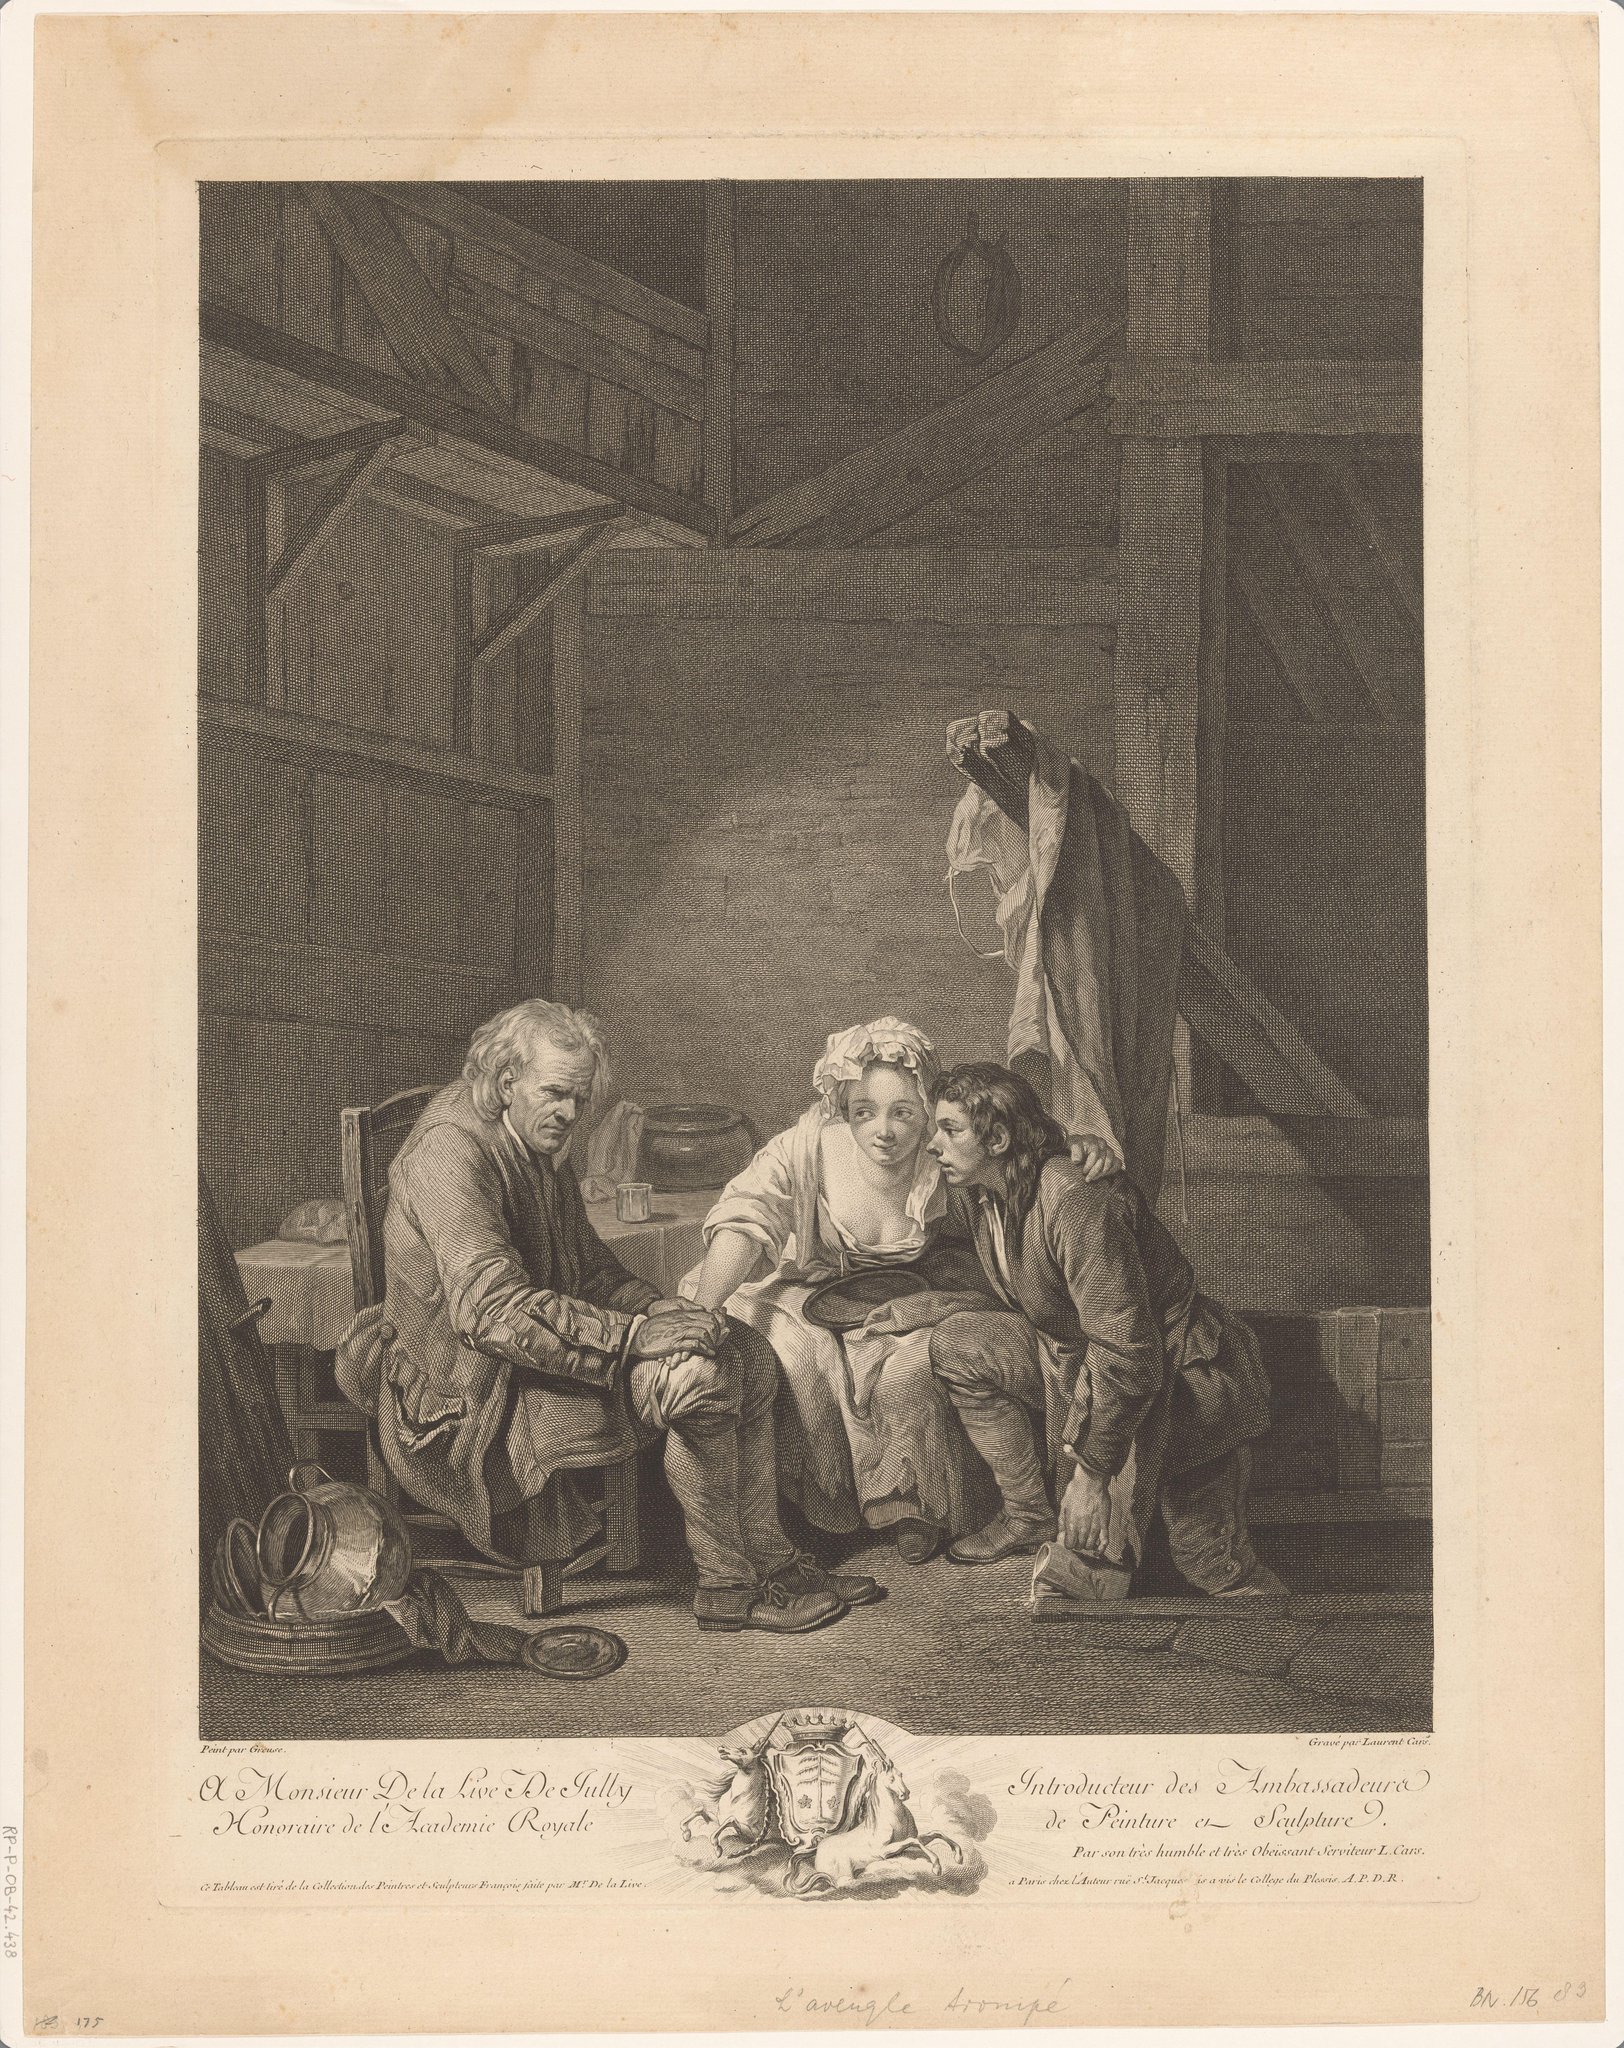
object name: print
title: Blinde man bedrogen door zijn jongere vrouw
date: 1709-1771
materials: paper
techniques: engraving, etching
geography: france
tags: blind, blindness, adultery, farm (building) - aa - civic architecture: inside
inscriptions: collector's mark: Lugt 2228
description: Het schilderij door Greuze werd in 1755 vervaardigd. De prent werd tentoongesteld in de Salon in 1757, nr. 152.